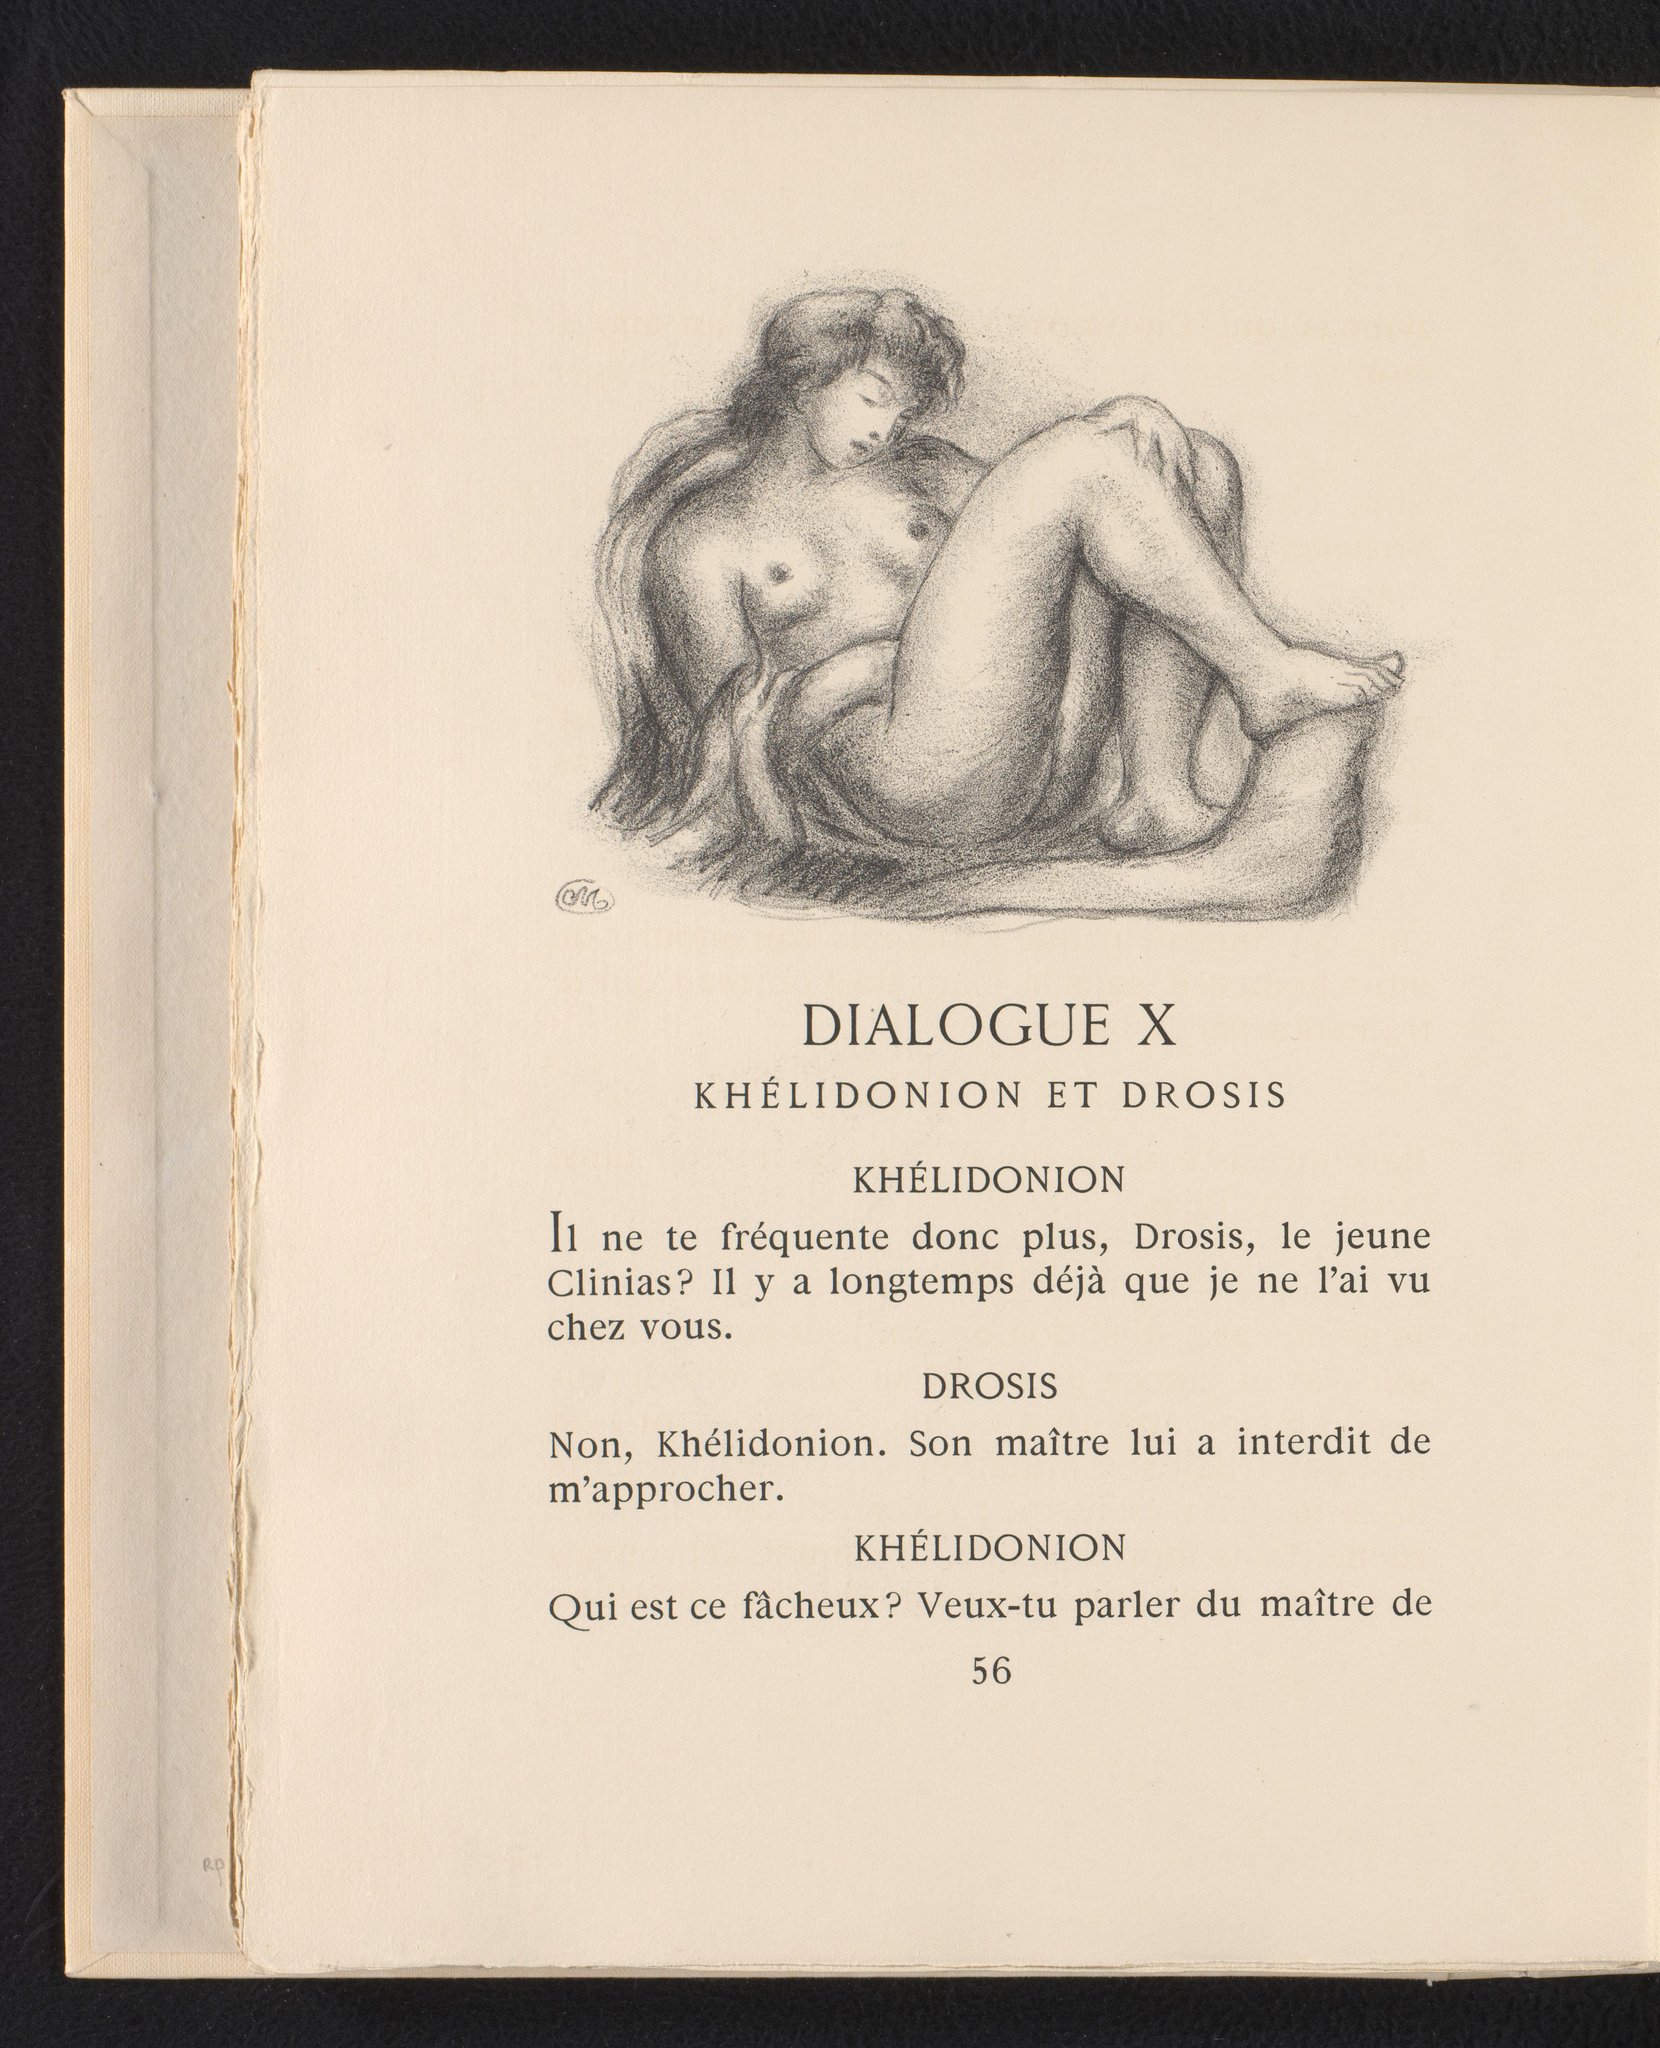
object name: book illustration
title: Achterover leunende naakte vrouw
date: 1948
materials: paper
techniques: letterpress printing, lithograph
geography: paris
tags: leaning figure - aa - female human figure, woman (showing herself) undressed, quasi-nude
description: Prent uit: Lucianus van Samosata. Dialogues des Courtisanes. [Vertaald uit het Grieks door] Charles Astruc. Parijs: s.n., 1948, p. 56.